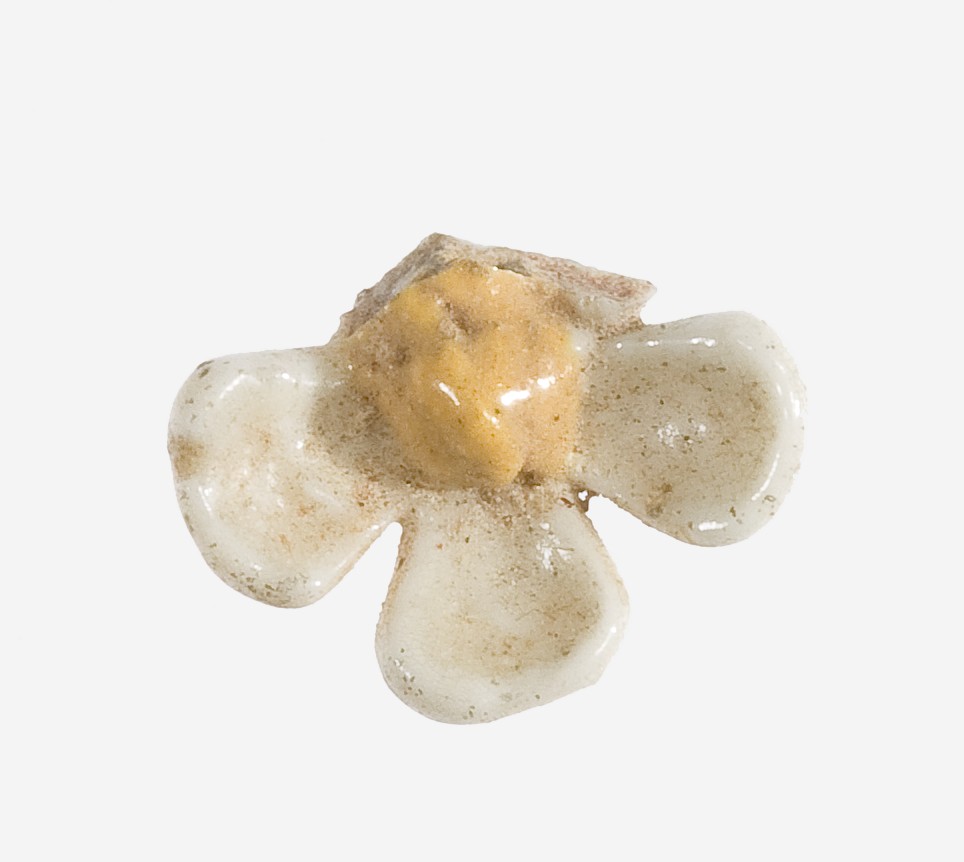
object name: pendant, daisy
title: Daisy Pendant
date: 1390-1352 BCE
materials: faience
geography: egypt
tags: daisies